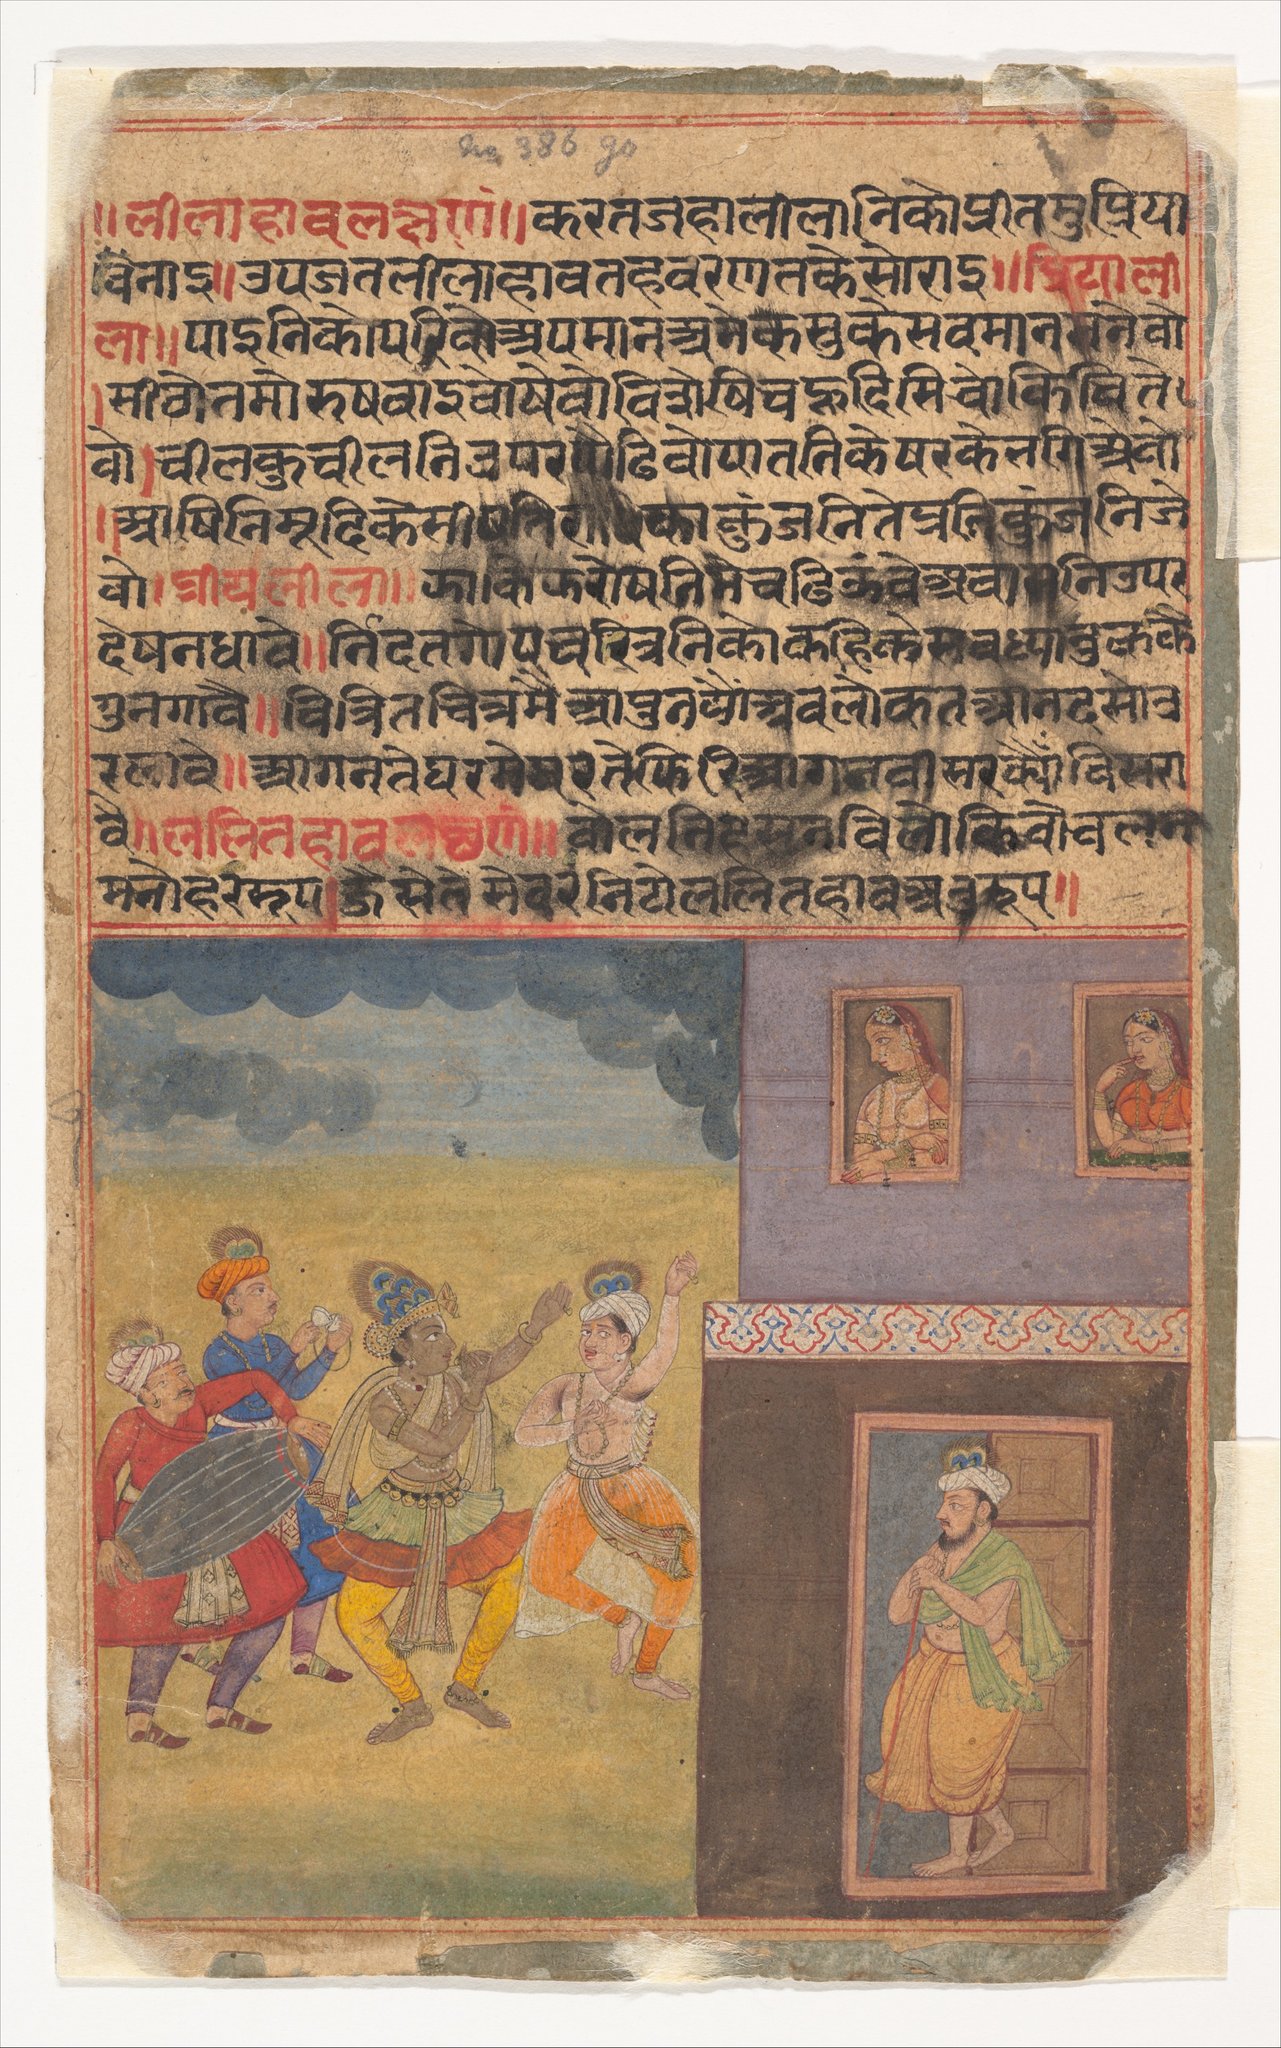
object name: folio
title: Krishna Dancing: Page from the Dispersed "Boston" Rasikapriya (Lover's Breviary)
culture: indian or rajasthan or amber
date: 1610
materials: gold, ink, paper, watercolor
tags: men,women,dancing,drums,krishna